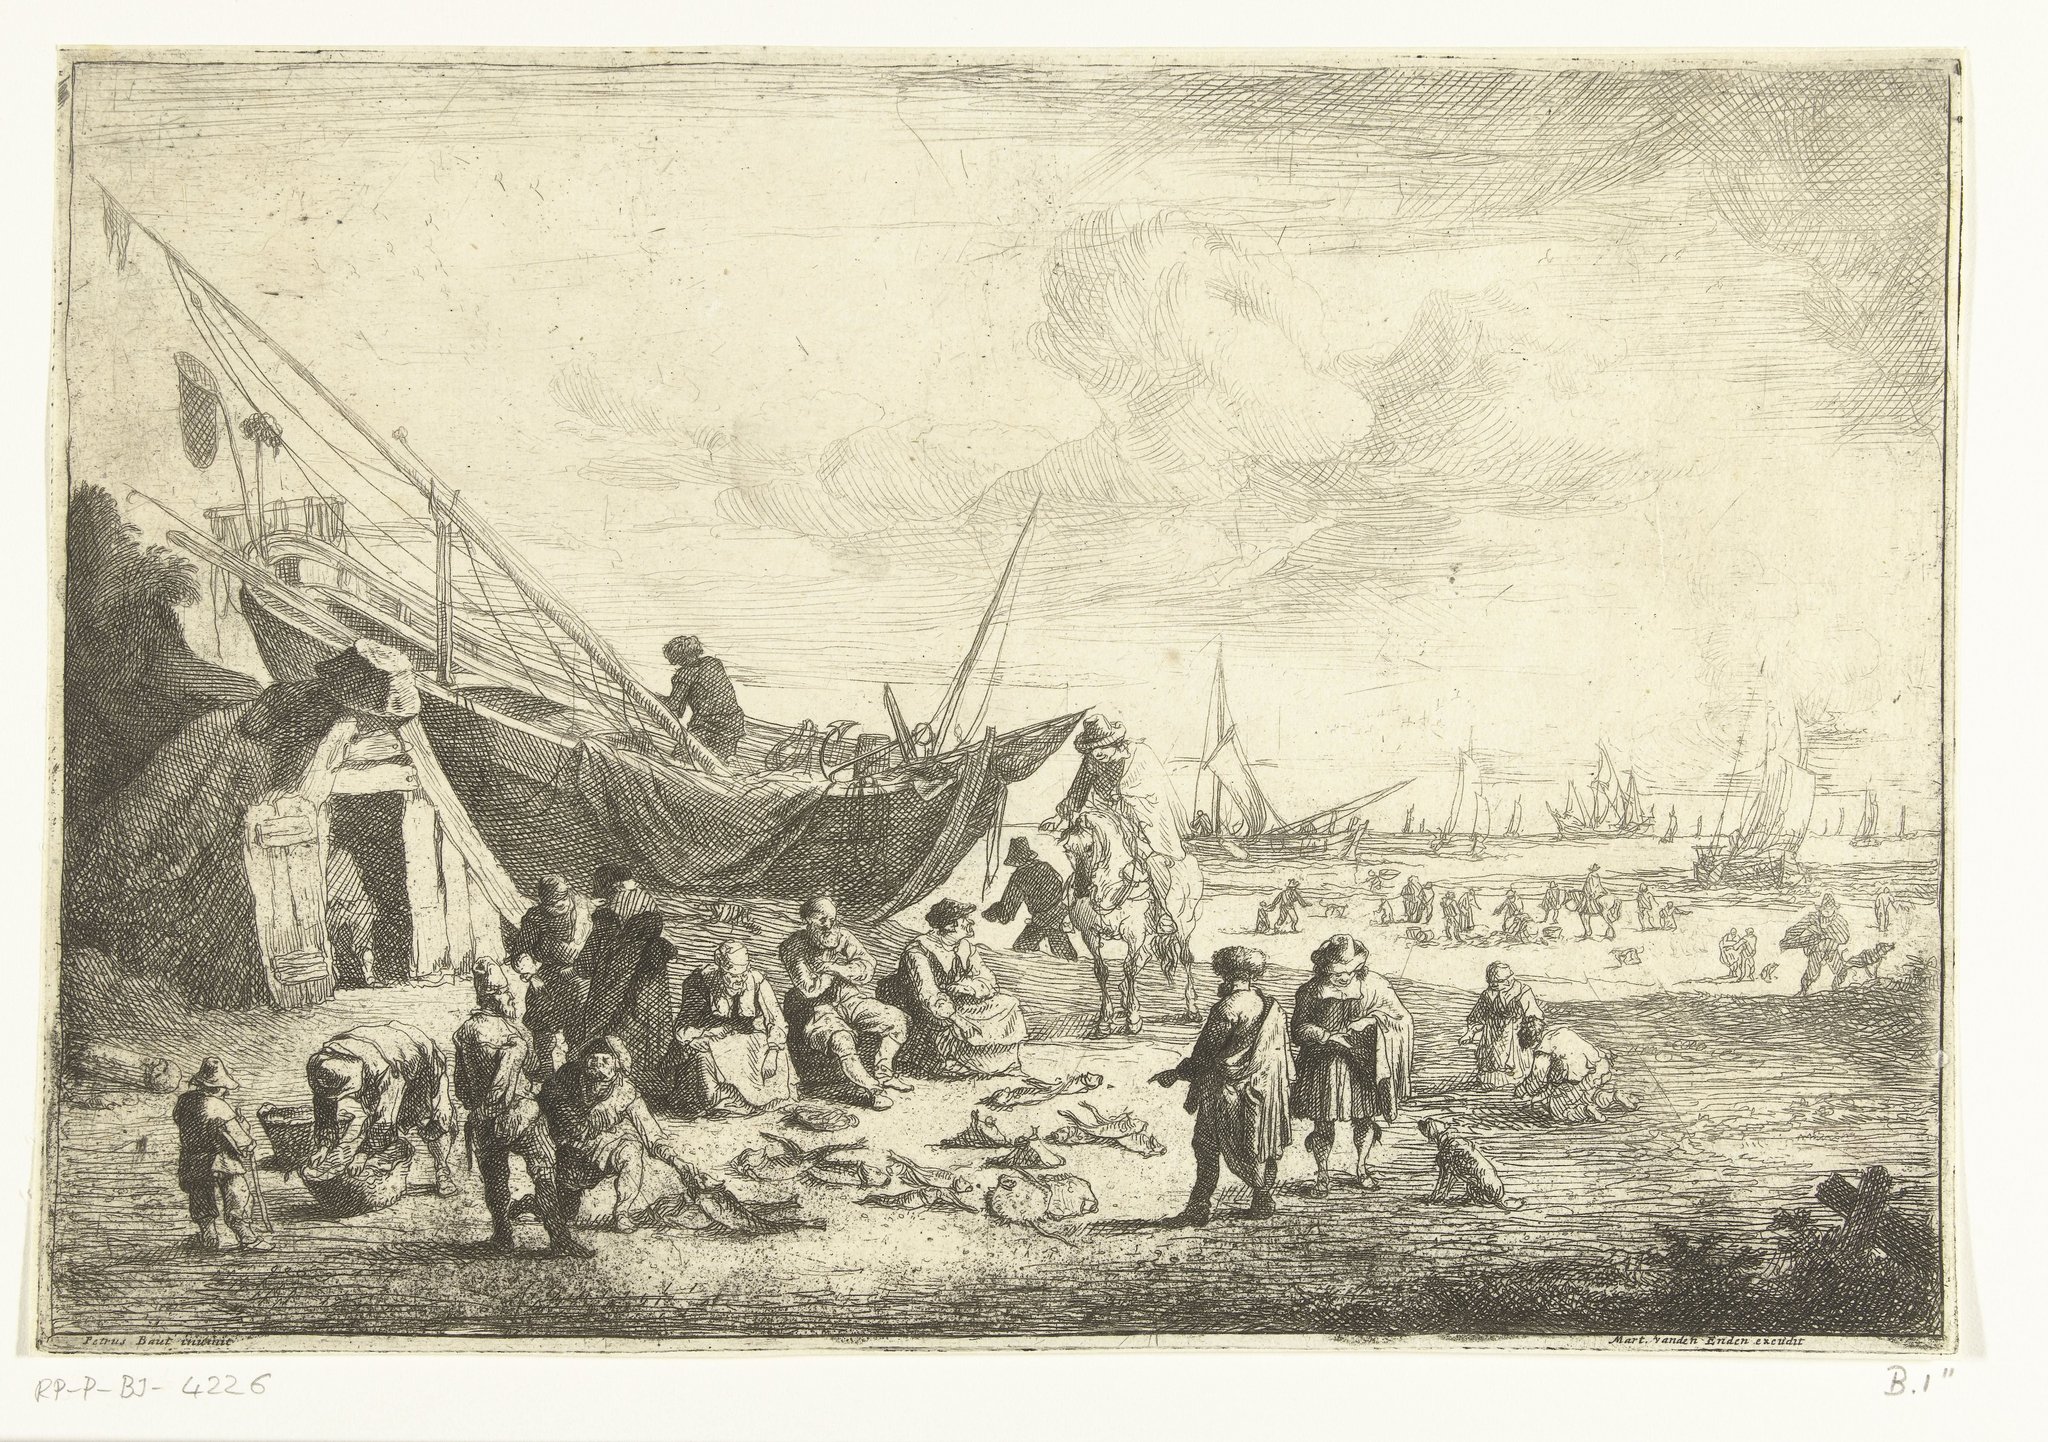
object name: print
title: Vismarkt te Scheveningen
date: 1664-1674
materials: paper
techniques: engraving, etching, intaglio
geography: brussels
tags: harbour, market, selling, fisherman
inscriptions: collector's mark: Lugt 240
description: Twee heren doen inkopen op de vismarkt in Scheveningen. De vissers en vissersvrouwen zitten op kisten aan het strand, voor hun op de grond ligt de vis uitgestald. Op de achtergrond zijn schepen op zee en aan het strand te zien.